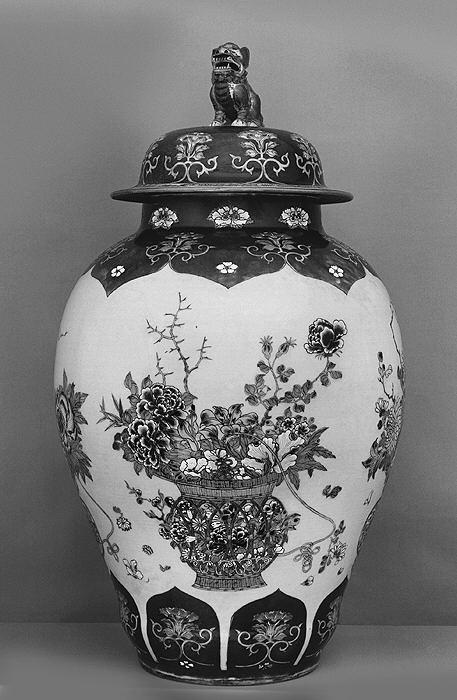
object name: covered jar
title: Covered jar with baskets of flowers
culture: chinese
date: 1701-1800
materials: enamel, porcelain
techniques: overglaze, painting, polychrome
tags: flowers